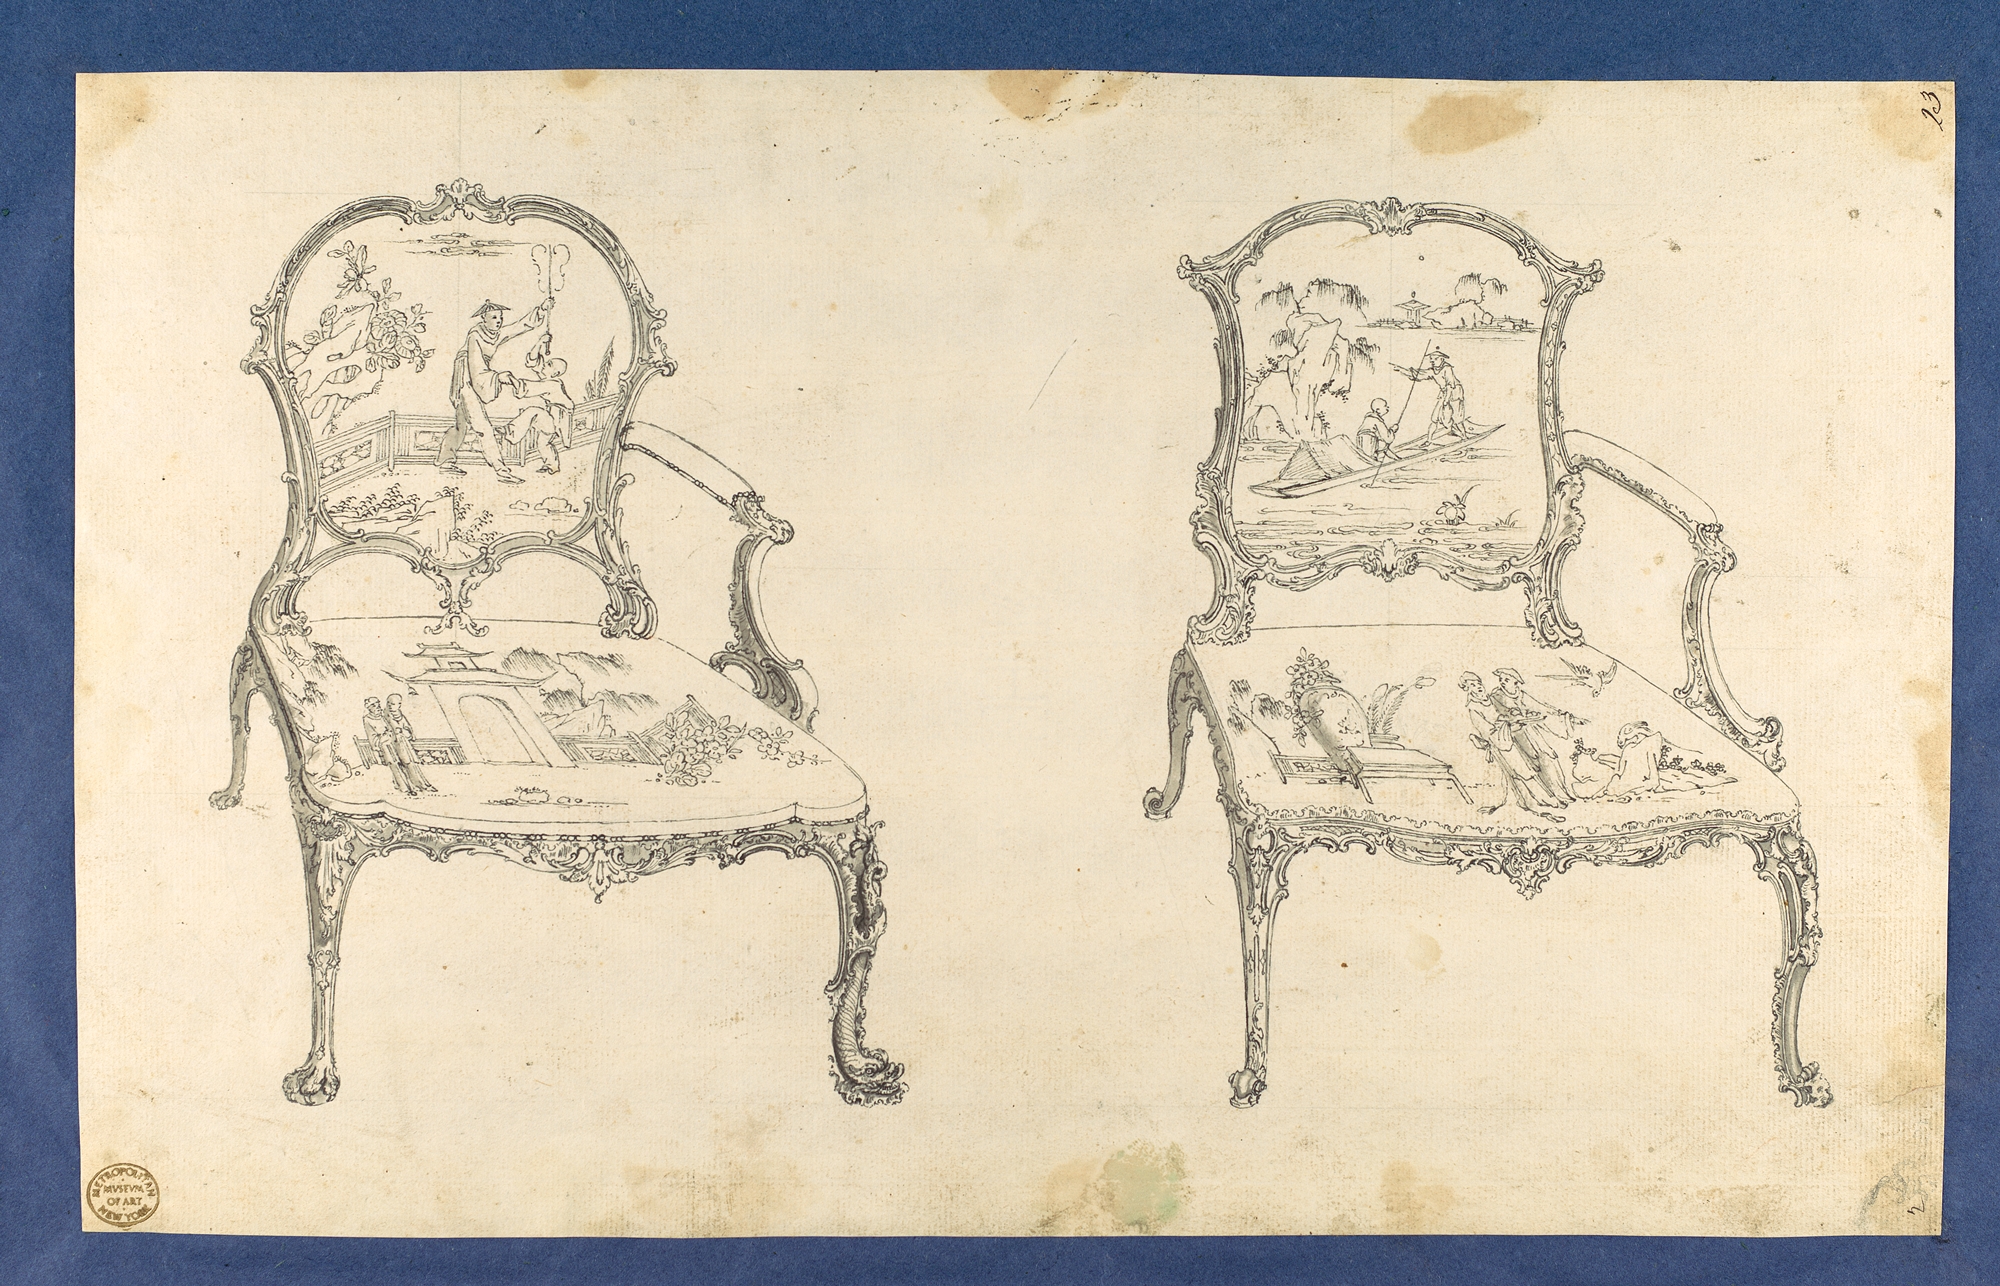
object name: drawing ornament architecture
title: Two French Chairs, in Chippendale Drawings, Vol. I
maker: thomas chippendale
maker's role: artist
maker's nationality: british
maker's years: 1718-1779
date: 1753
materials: ink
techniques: wash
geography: london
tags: chairs